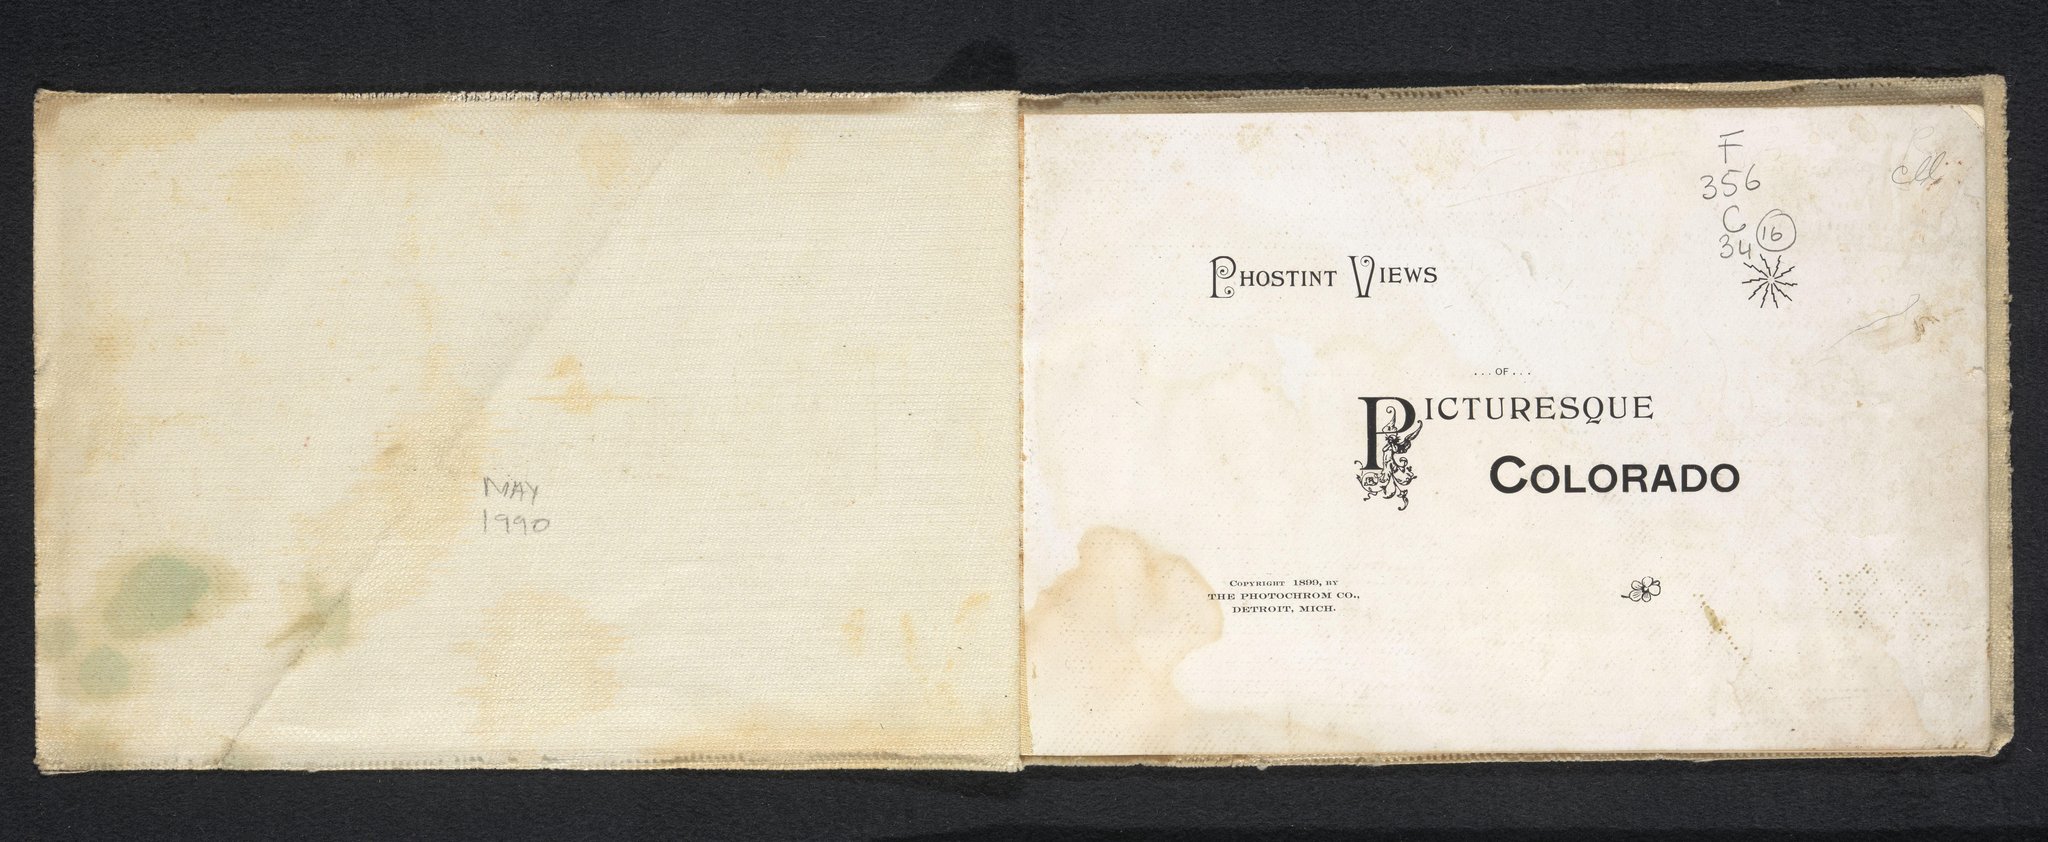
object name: book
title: Phostint views of picturesque Colorado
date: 1875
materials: paper, textile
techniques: lithograph, printing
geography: detroit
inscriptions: inscription: ‘May 1990’